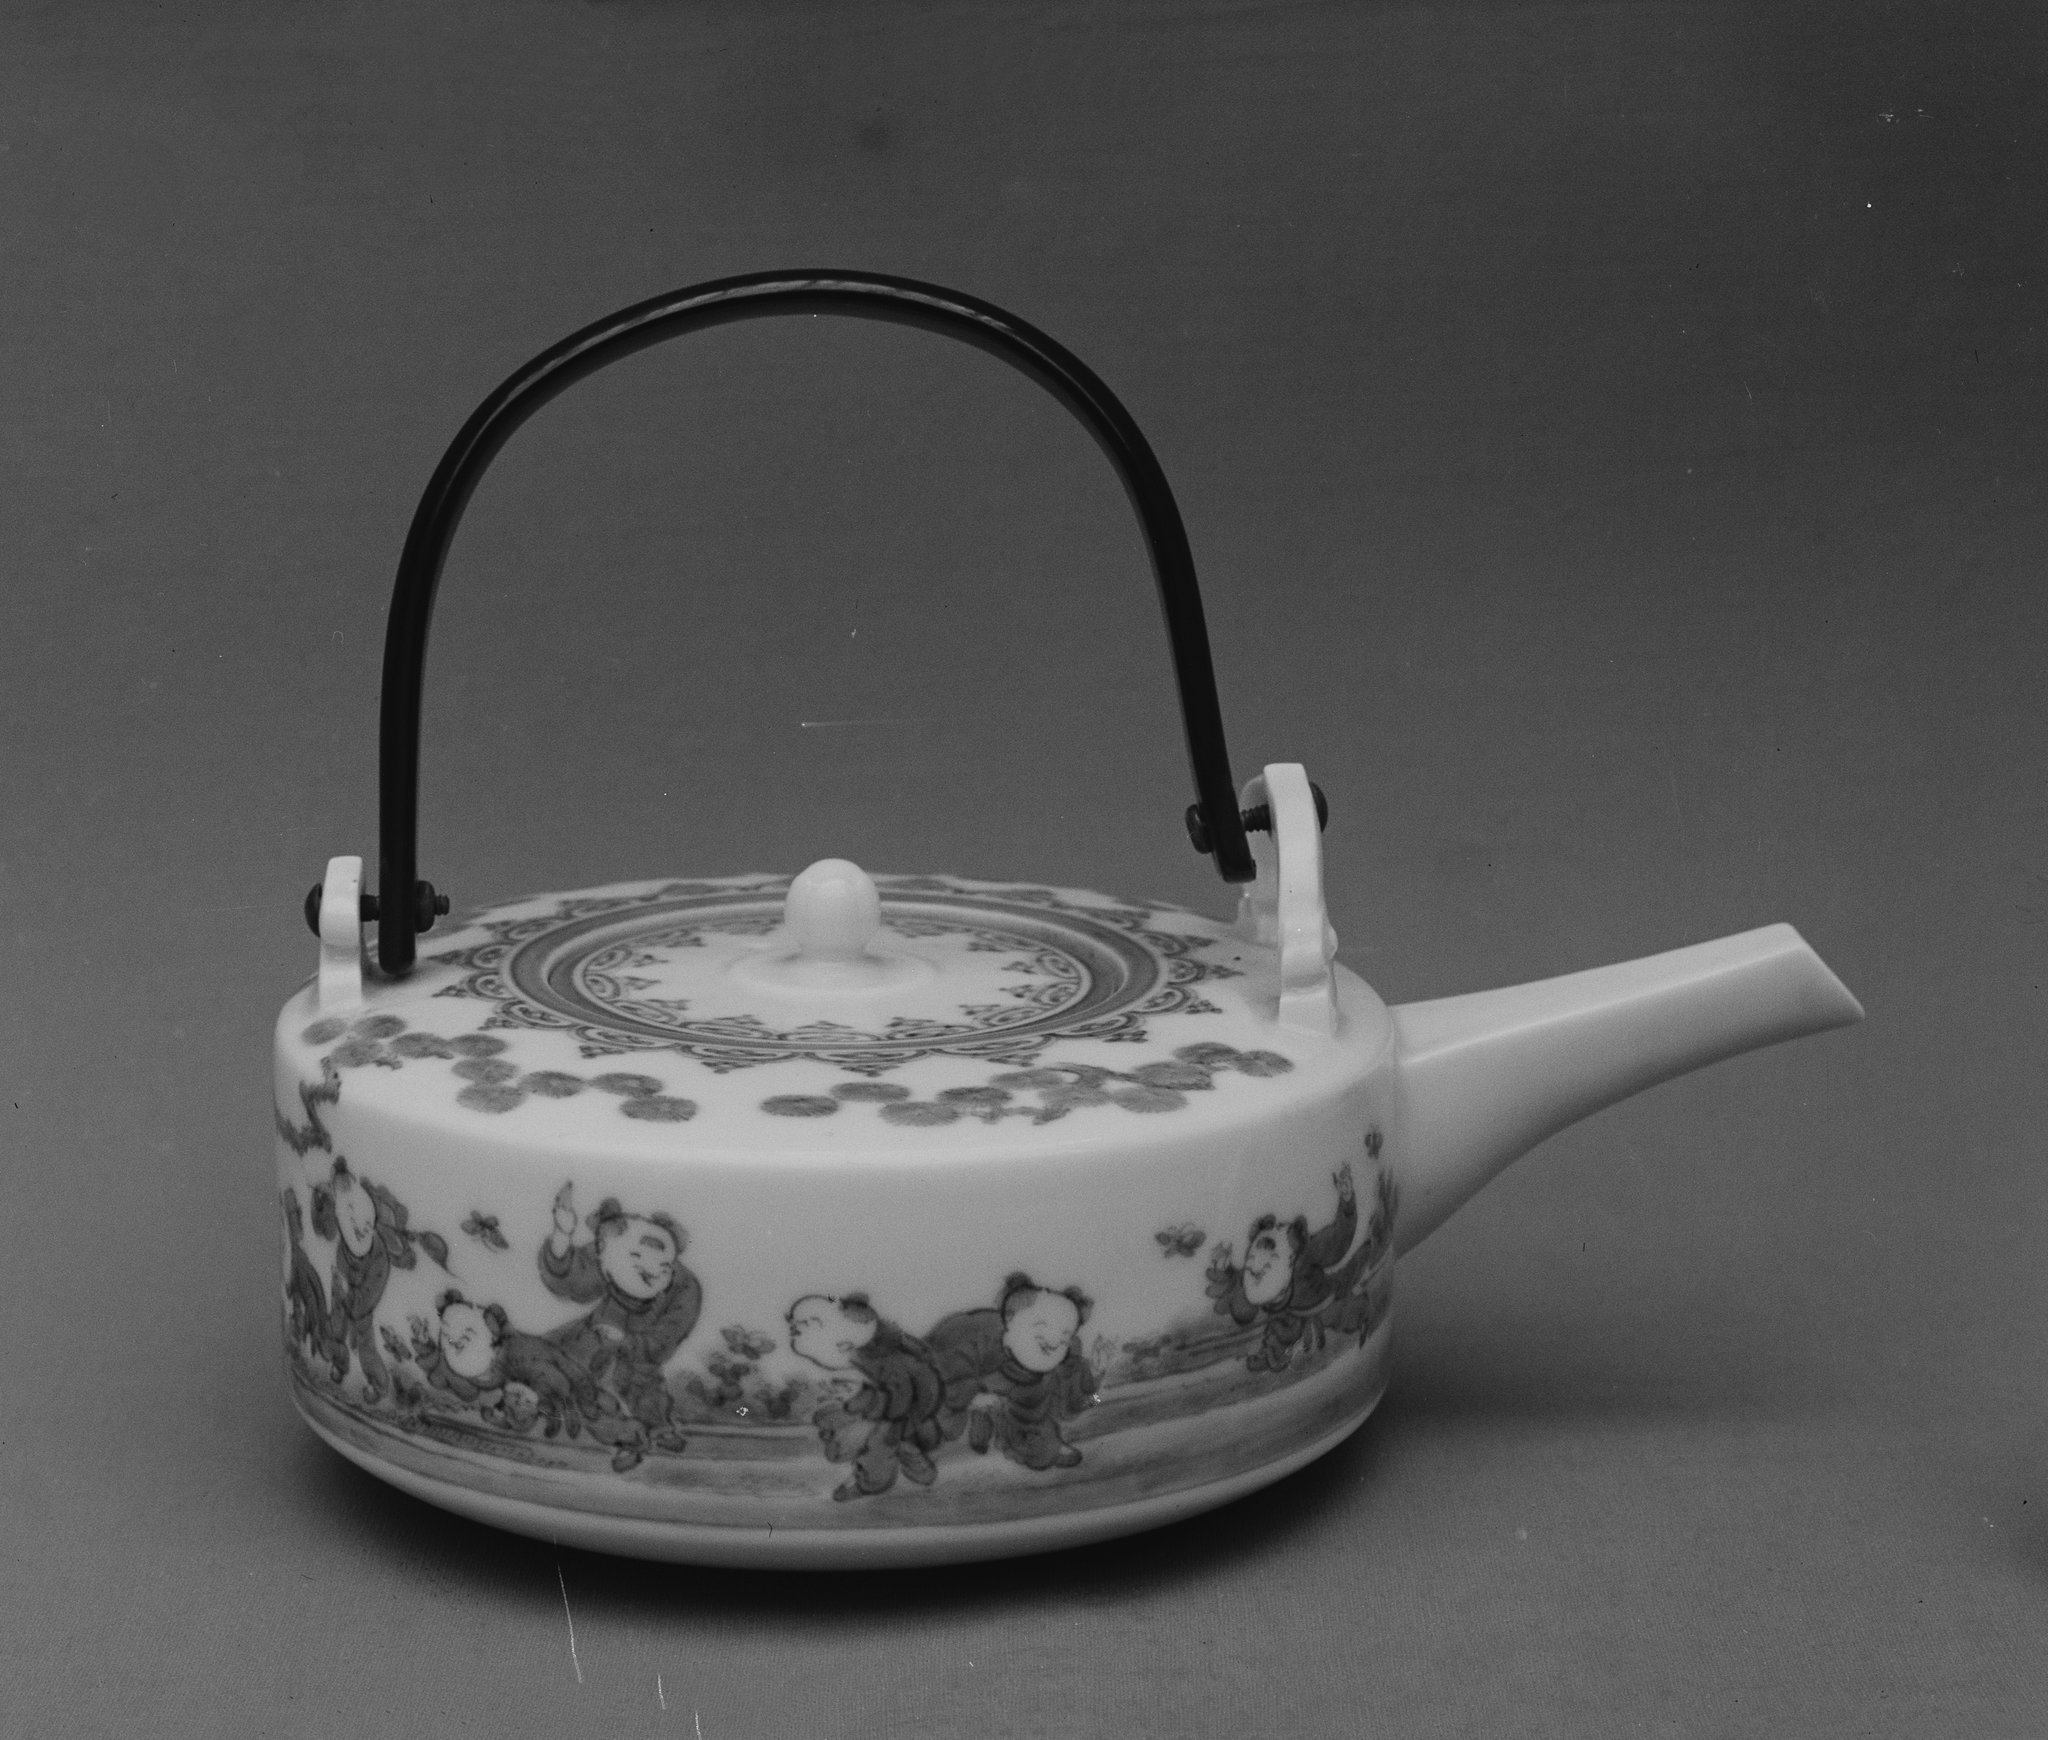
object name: wine bottle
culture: japanese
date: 1820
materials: glaze, porcelain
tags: human figures